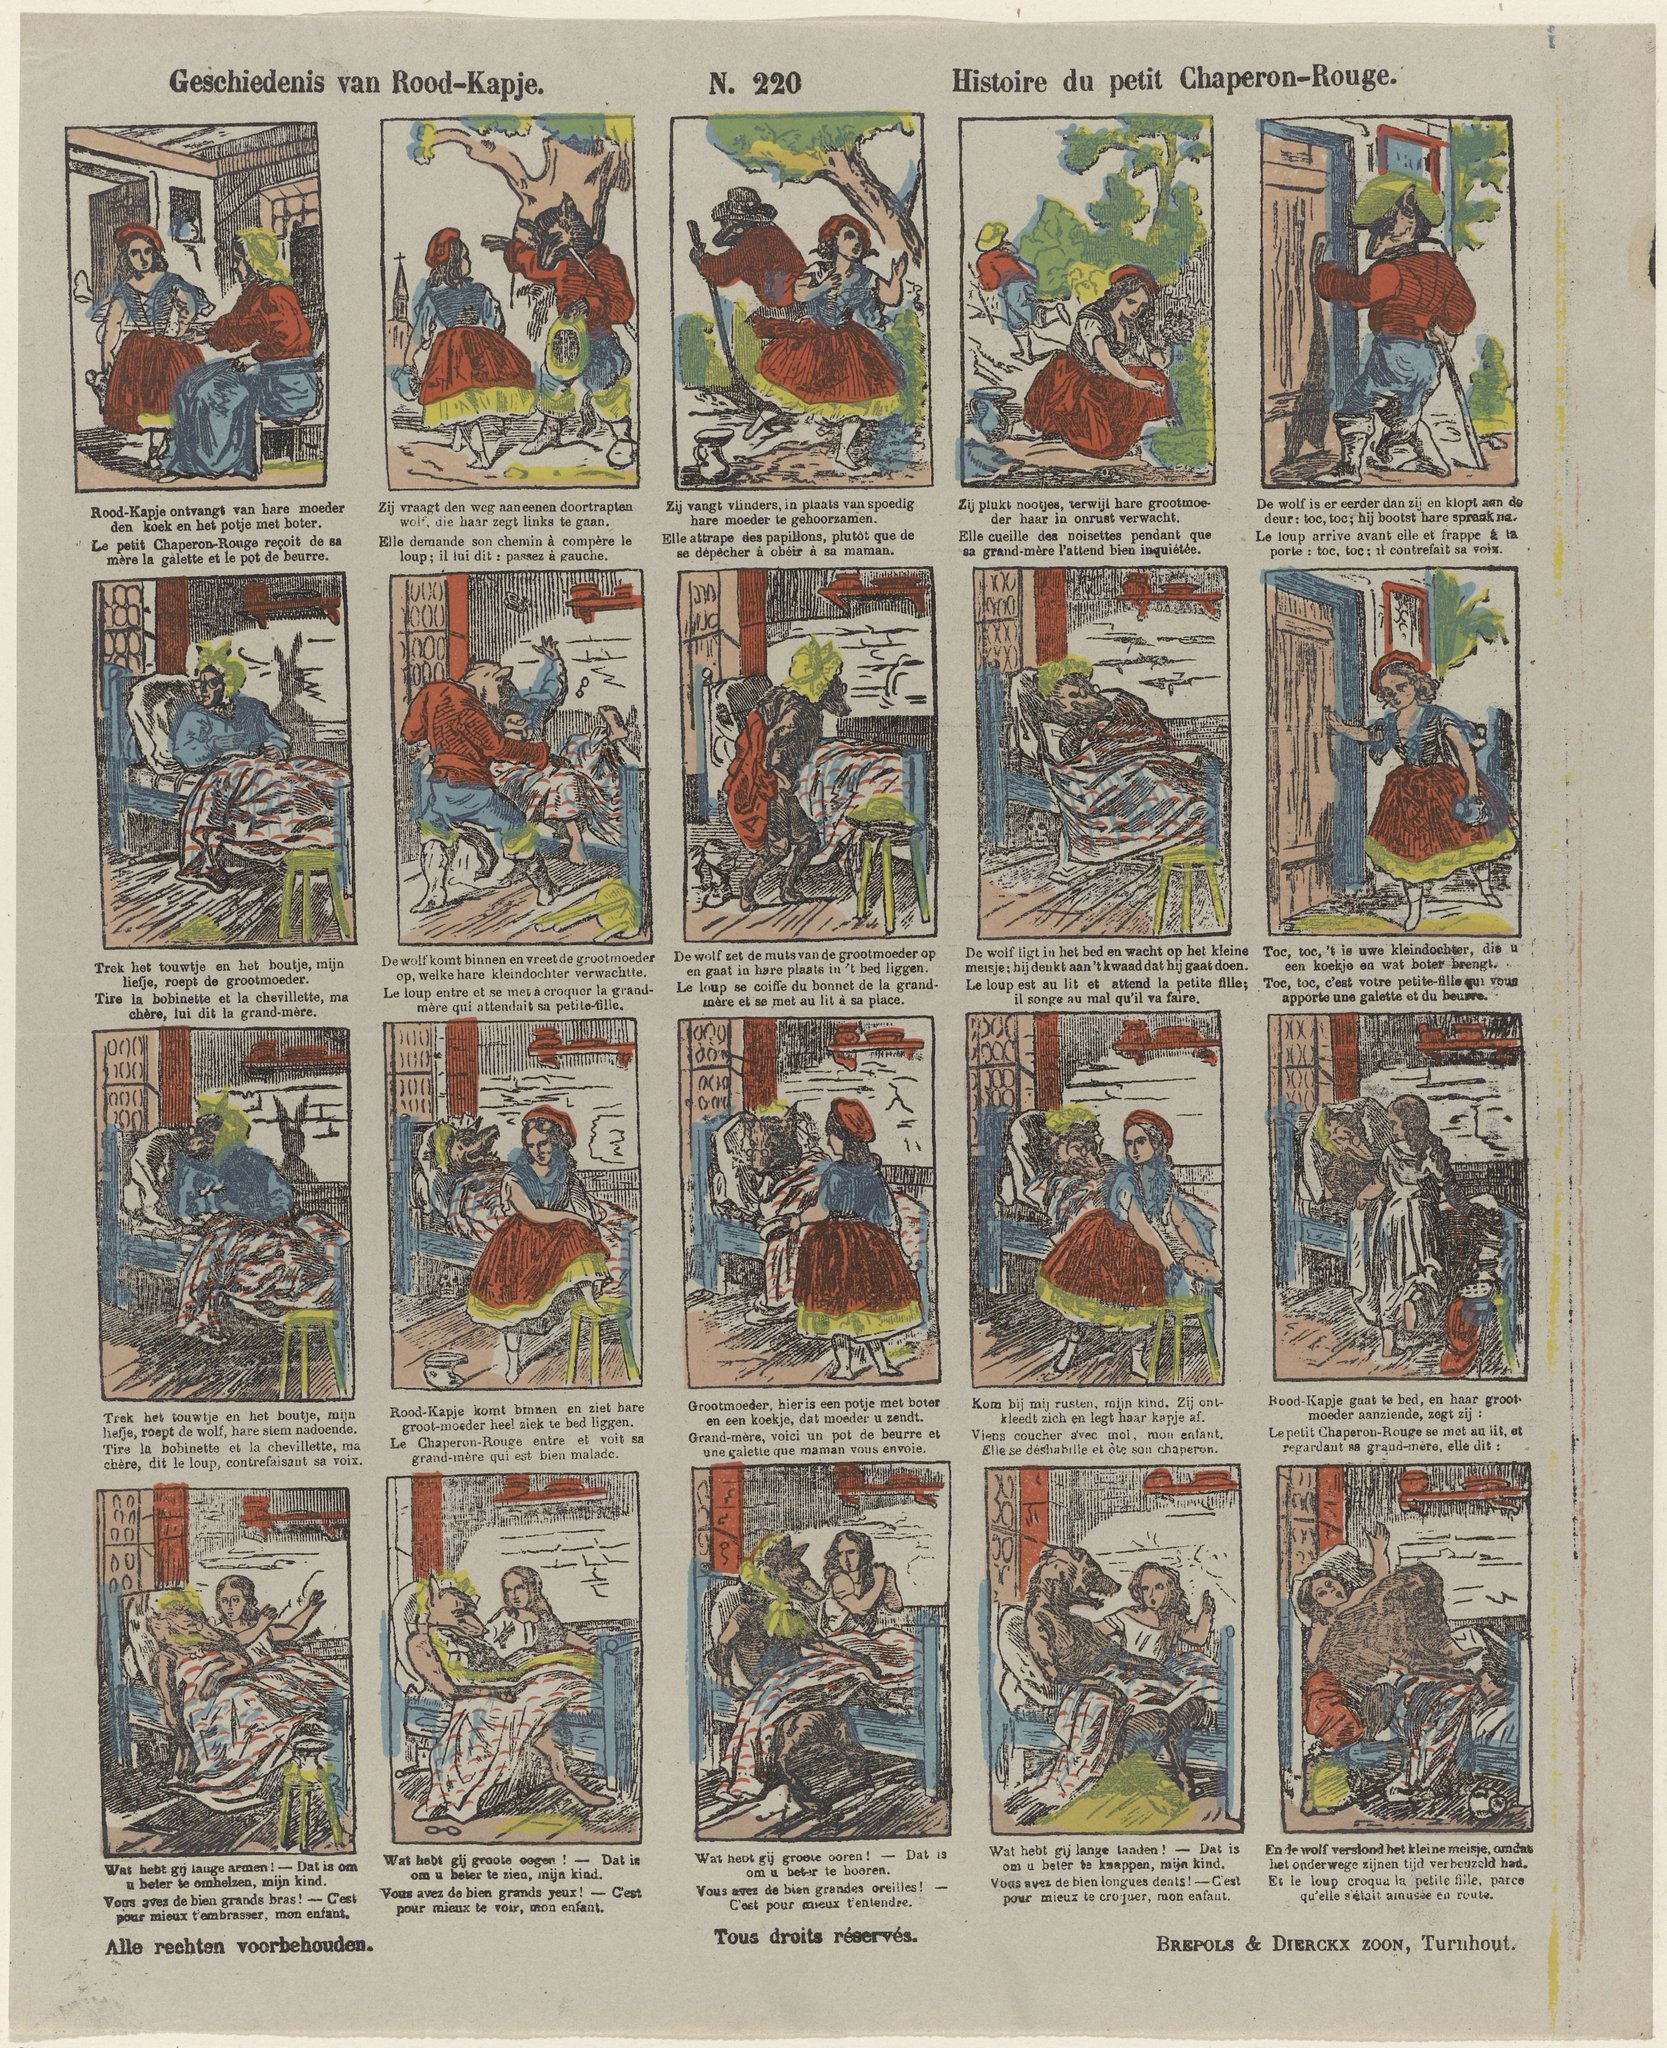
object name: print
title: Geschiedenis van Rood-kapje / Histoire du petit Chaperon-Rouge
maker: Anonymous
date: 1833-1911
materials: paper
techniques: lithograph, letterpress printing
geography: turnhout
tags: tales and fairy tales, tales and fairy tales: little red riding-hood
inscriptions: collector's mark: Lugt 2760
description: Blad met 20 voorstellingen uit het sprookje van Roodkapje. Onder elke voorstelling een onderschrift in het Nederlands en in het Frans. Genummerd midden boven: N. 220.